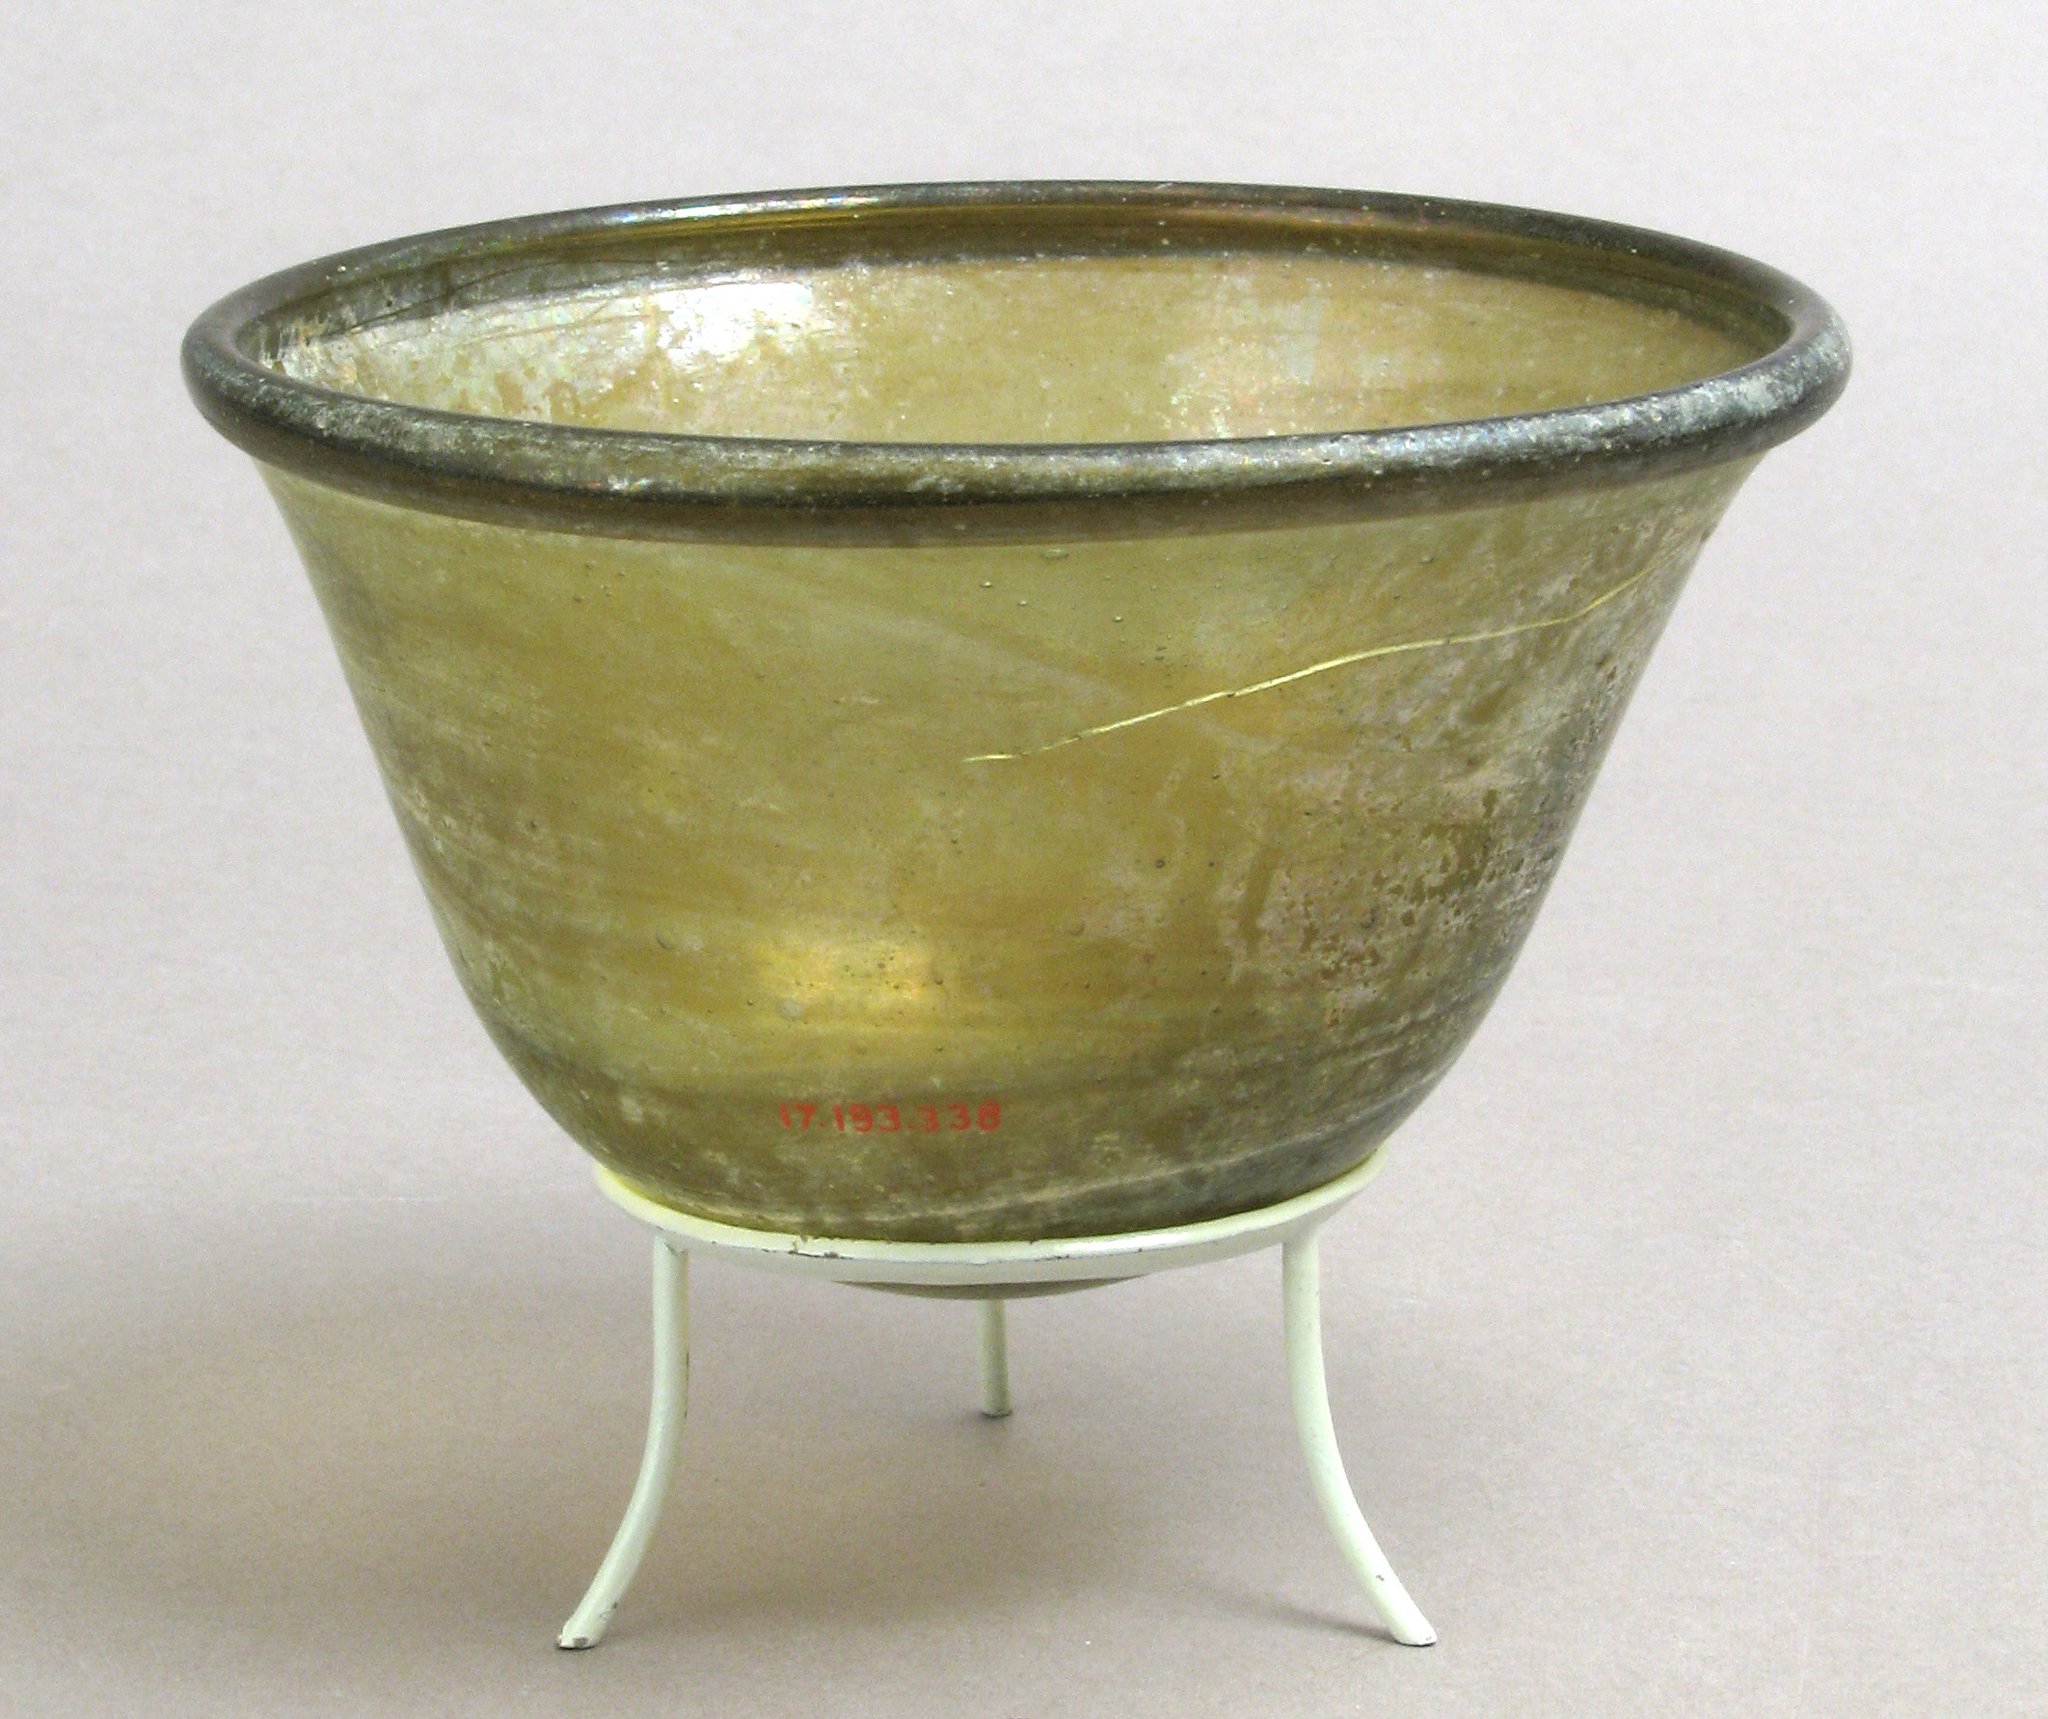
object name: cup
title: Palm Cup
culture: frankish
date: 601-800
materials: glass